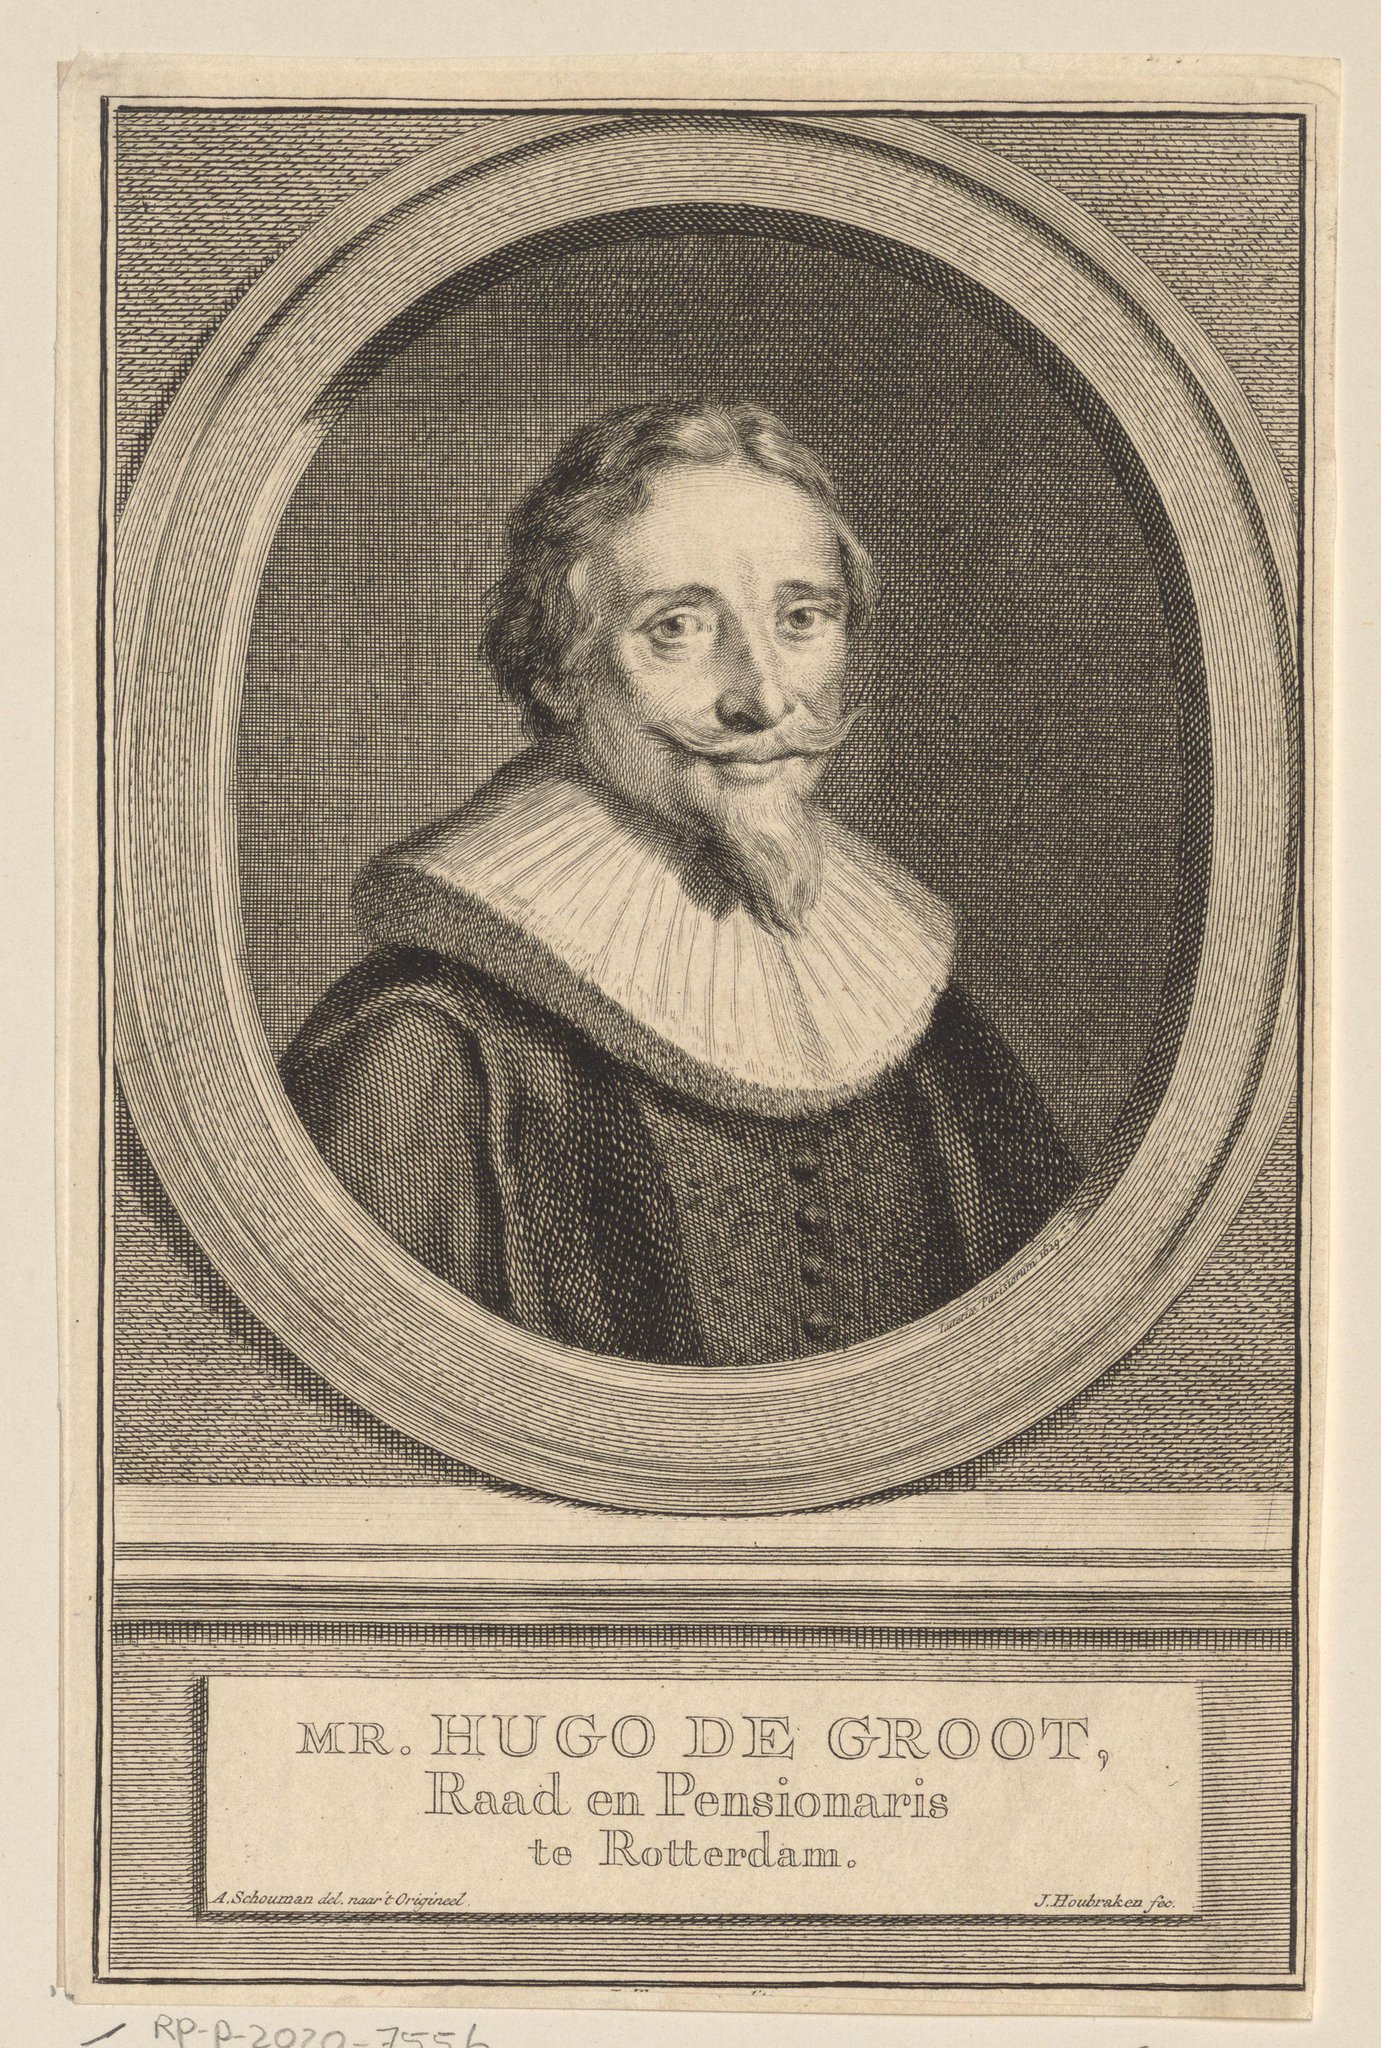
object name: print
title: Portret van Hugo de Groot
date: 1749-1759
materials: paper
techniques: engraving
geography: amsterdam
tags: delft, hugo de groot, historical persons, portrait of a writer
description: Prent uit: Wagenaar, Jan. Vaderlandsche historie, vervattende de geschiedenissen der nu Vereenigde Nederlanden, inzonderheid die van Holland (...). Amsterdam, Isaak Tirion, [1749-1759].